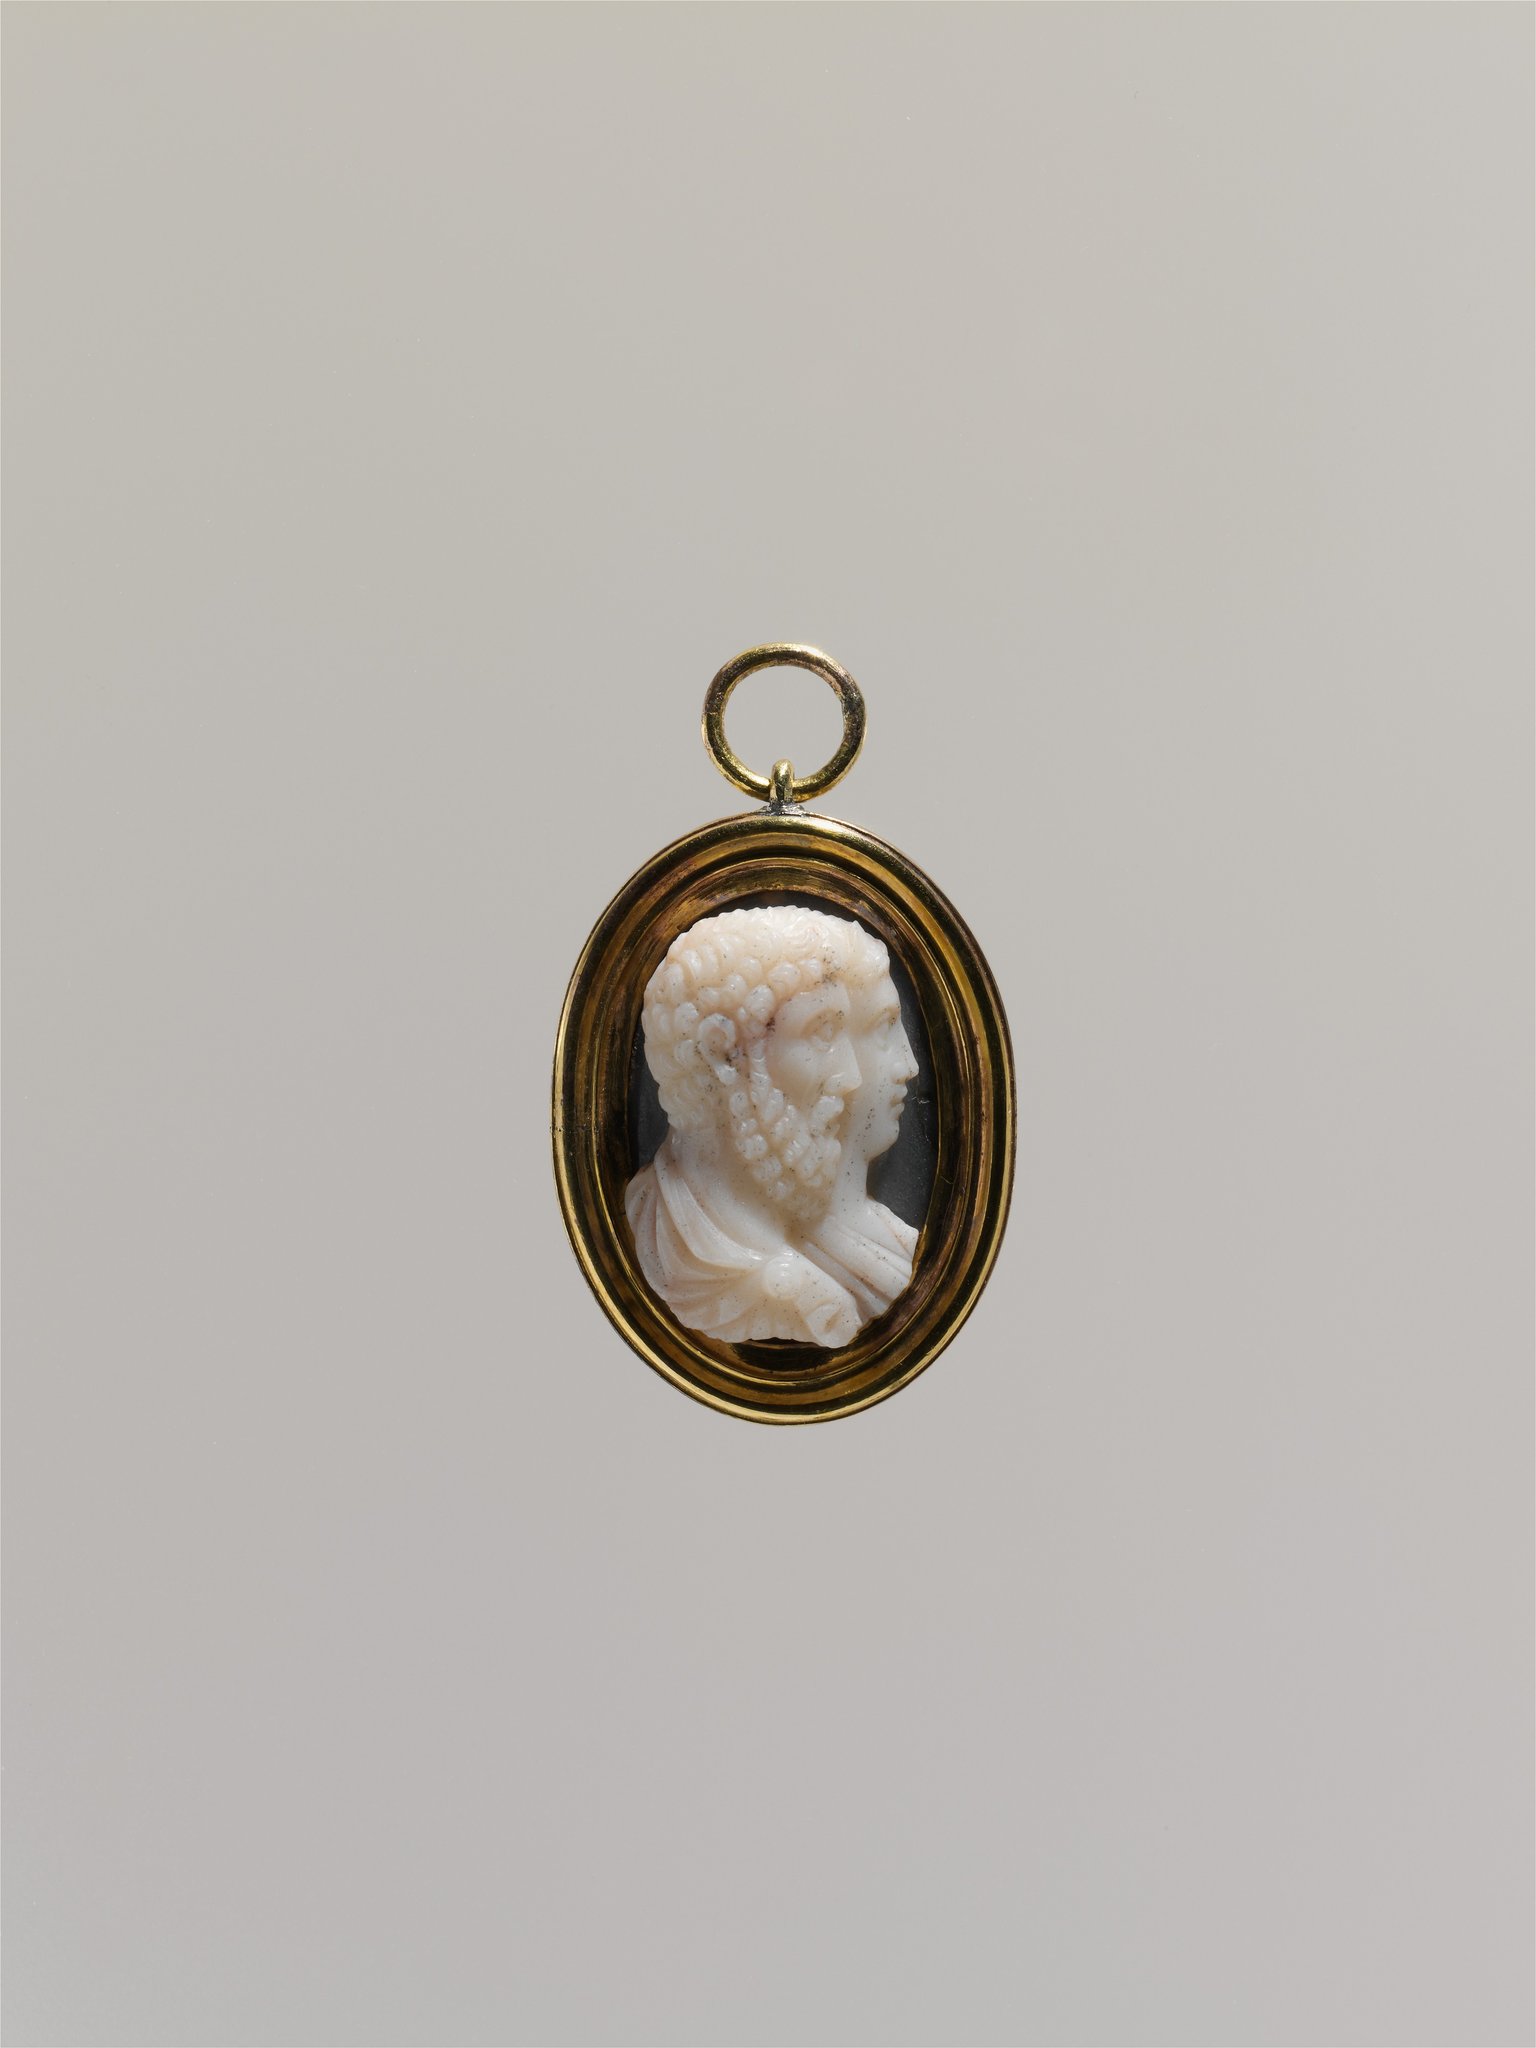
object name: cameo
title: Jugate heads of Marcus Aurelius (Marcus Aurelius Antoninus, 121–180) and Faustina (Anna Galeria Faustina, d. 175 or 176)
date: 1601-1700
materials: gold, onyx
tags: men,profiles,women